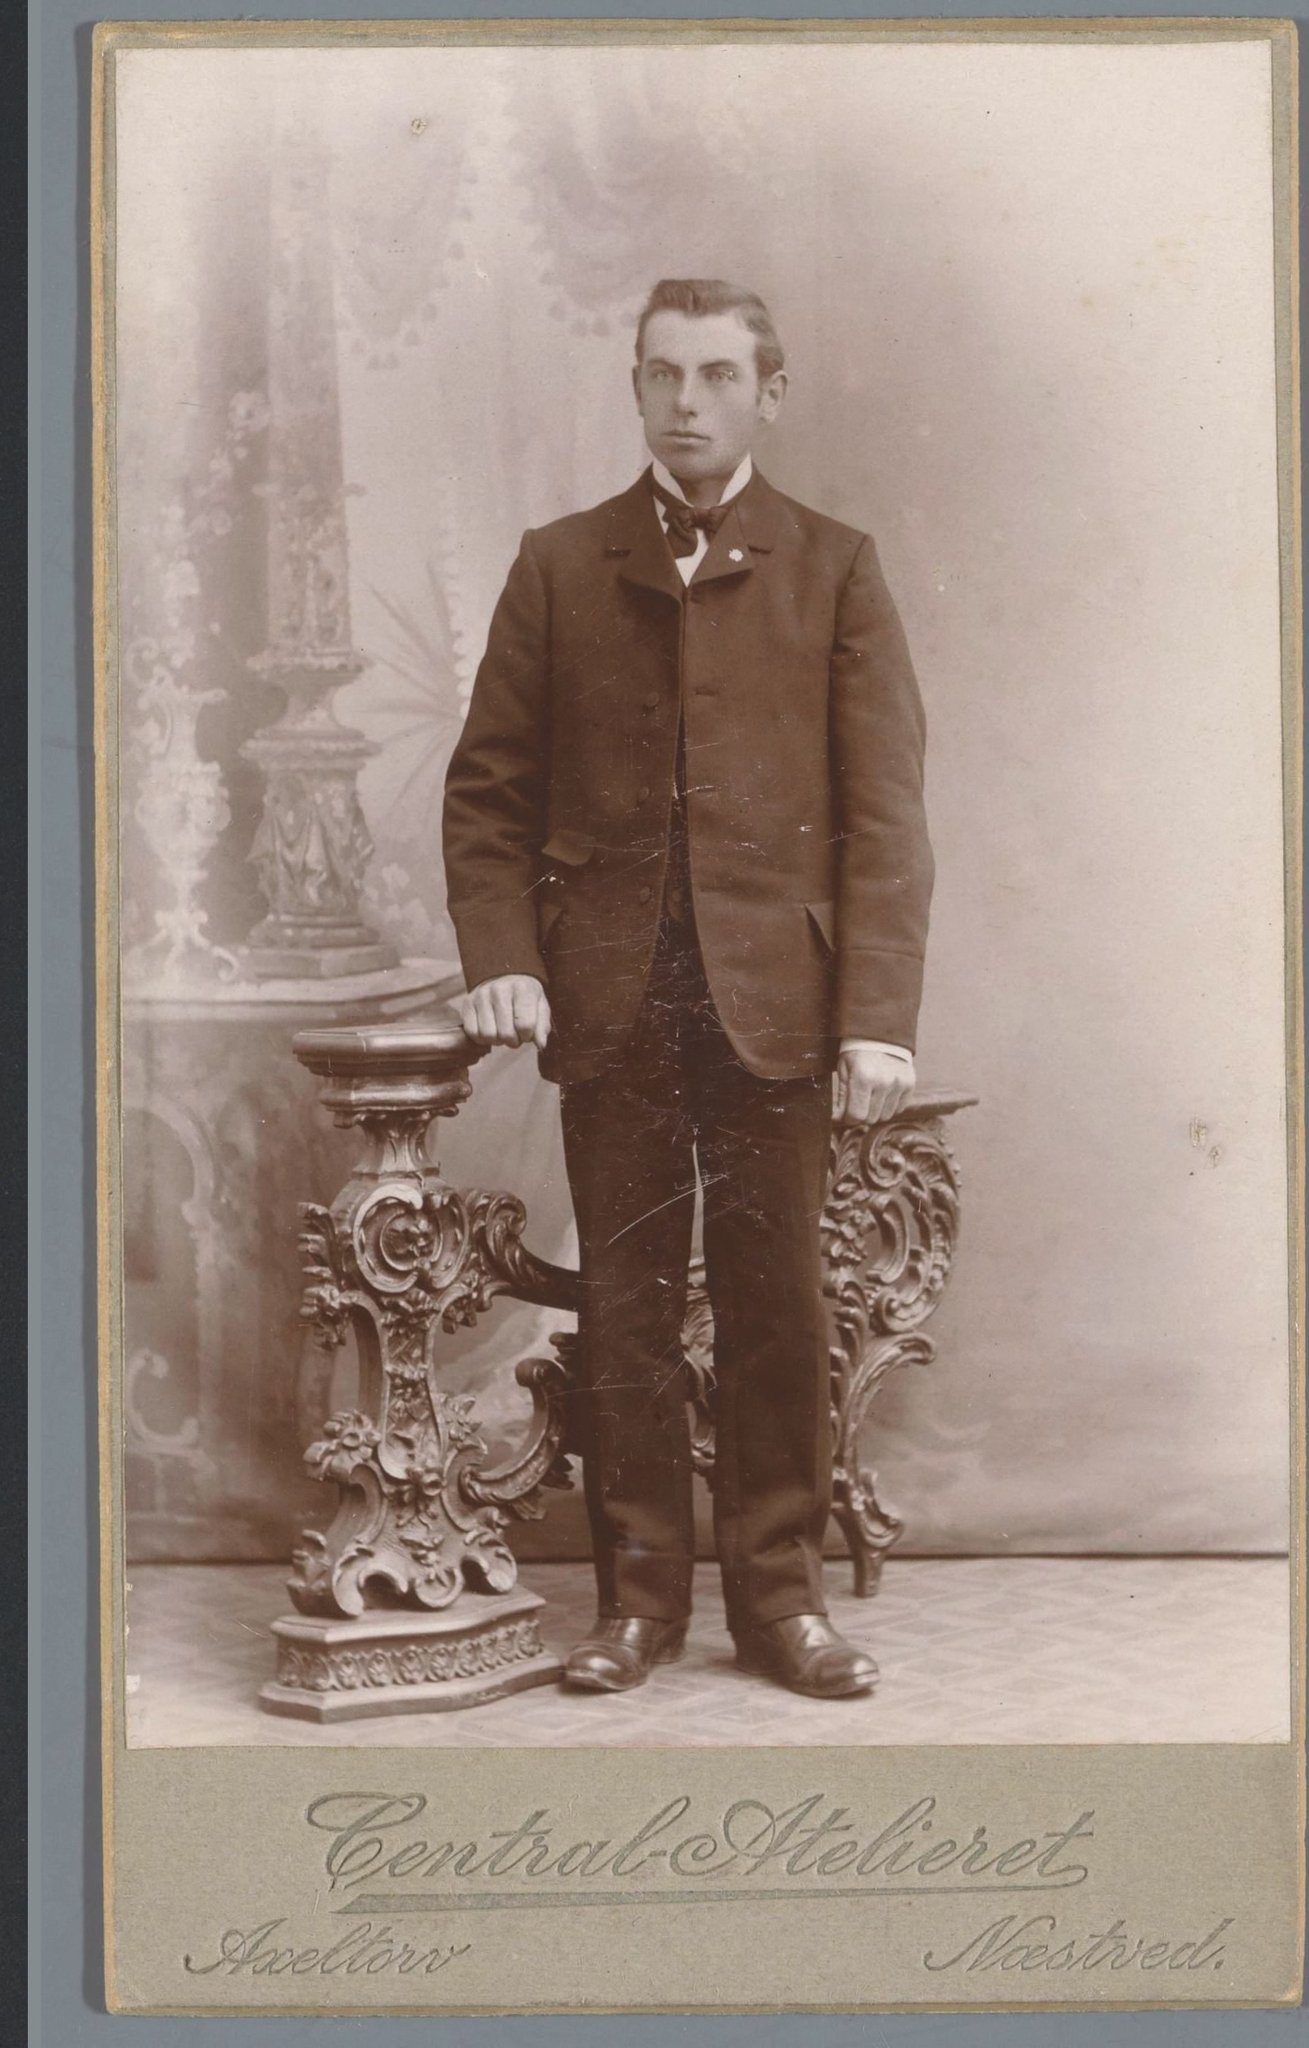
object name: carte de visite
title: Portret van een onbekende man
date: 1880-1910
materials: cardboard, photographic support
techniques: gelatin silver print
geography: copenhagen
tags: adult man, historical persons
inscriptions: address: ‘Central-Atelieret/ Axeltorv Næstved.’, inscription: ‘Wiens’